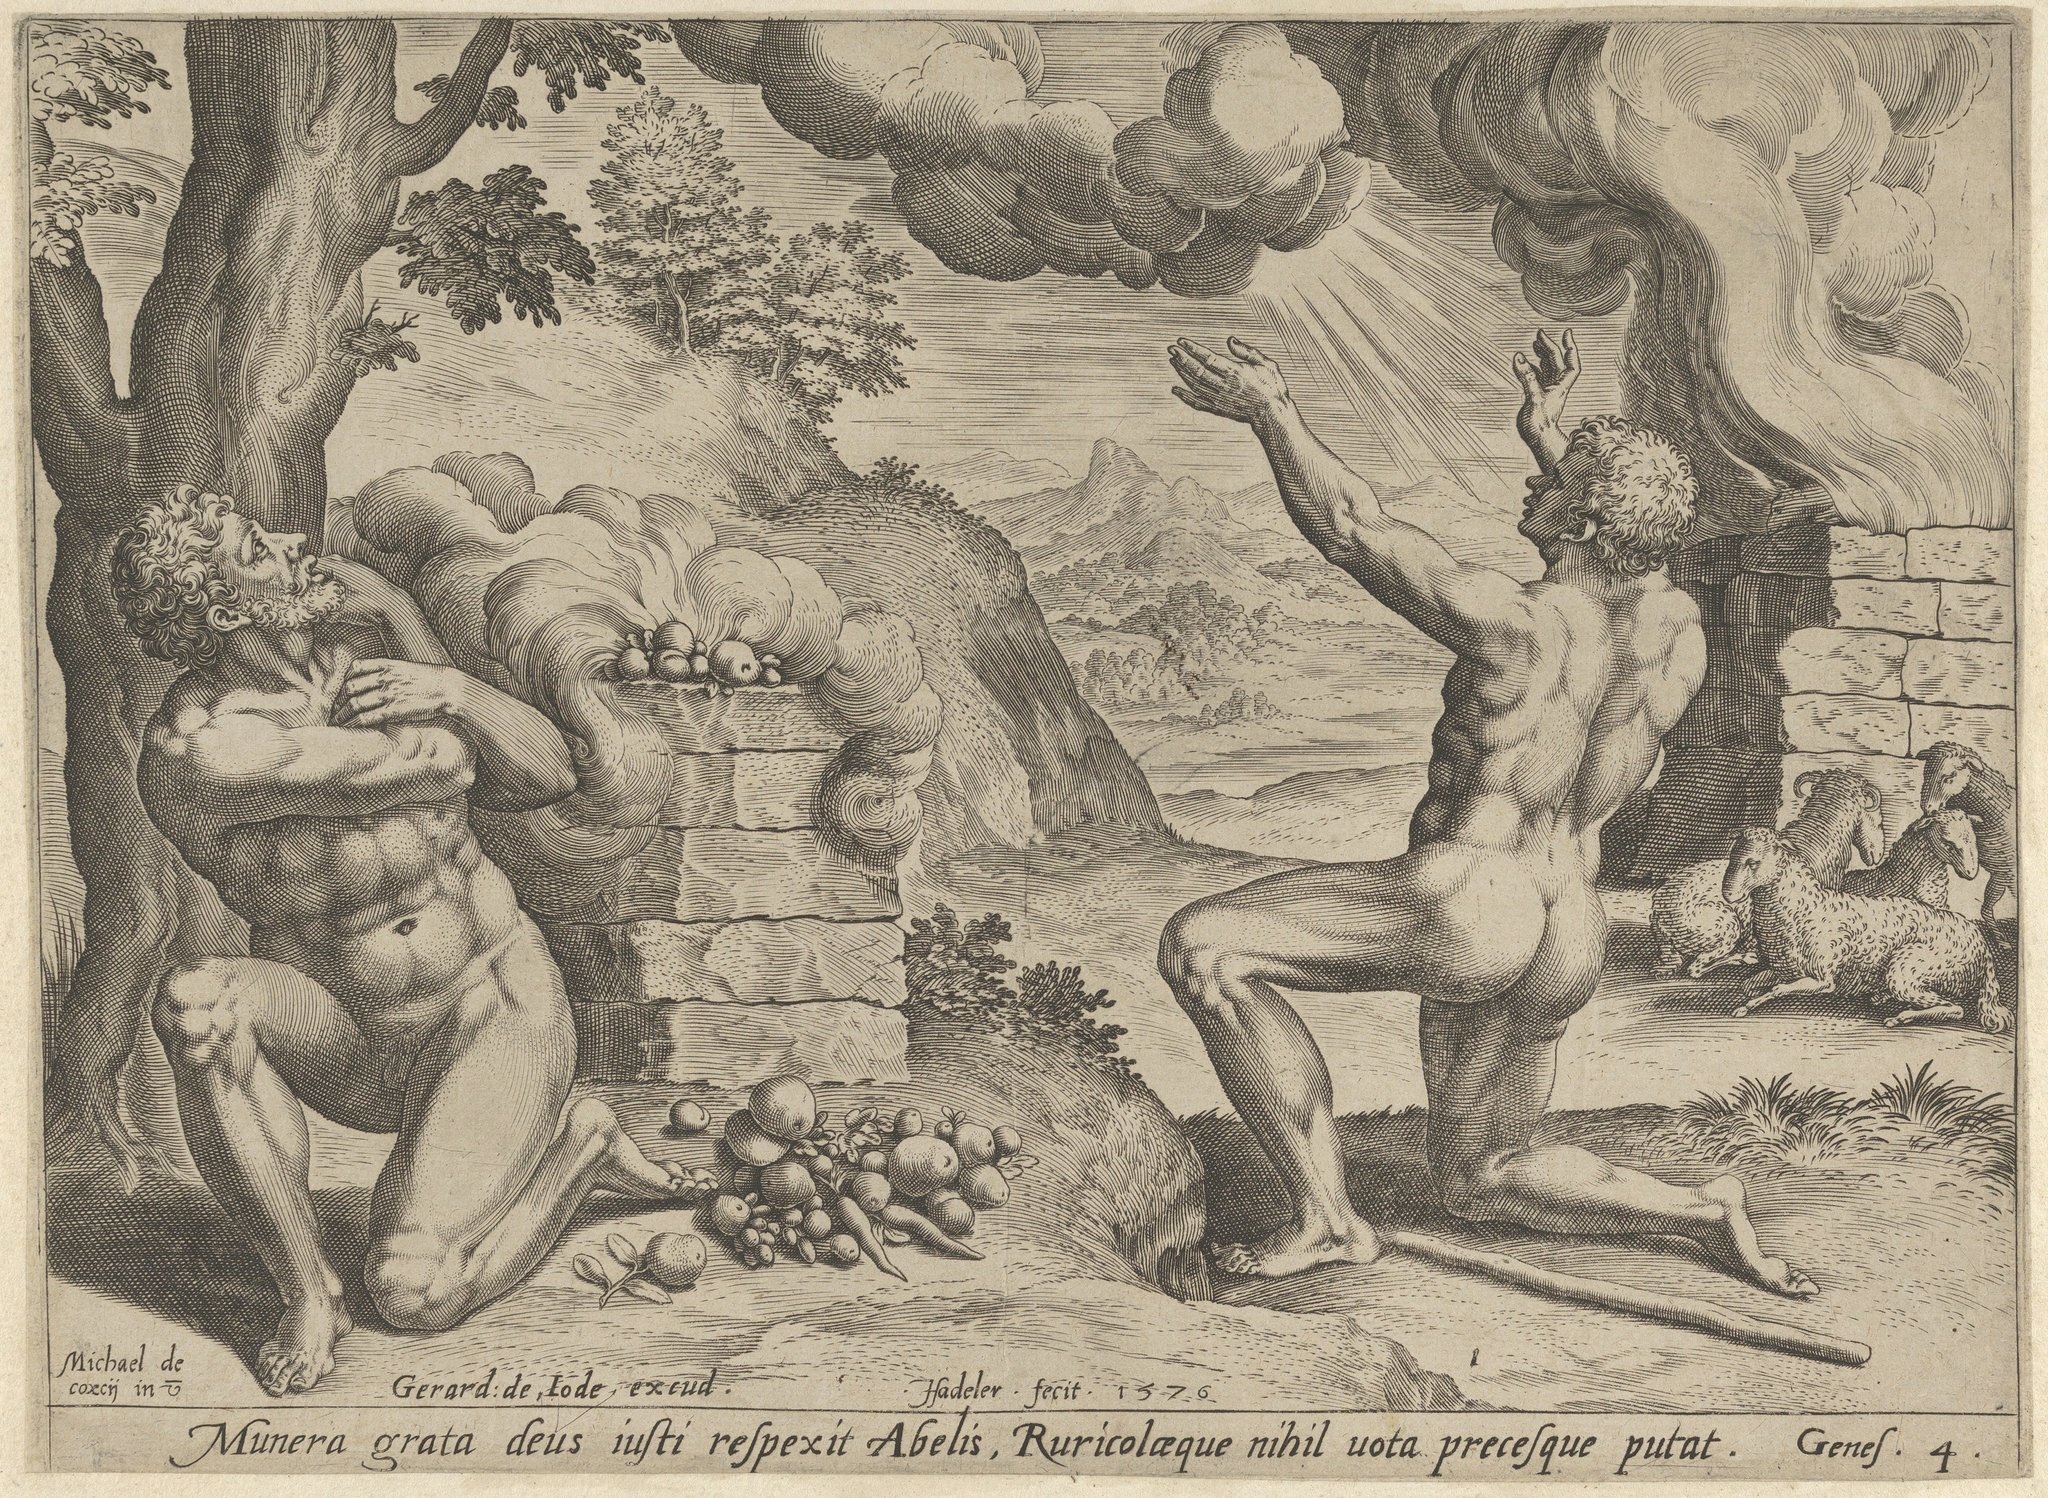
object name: print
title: The Sacrifice of Abel, plate 1 from "The Story of Cain and Abel"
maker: johann sadeler (i)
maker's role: artist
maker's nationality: netherlandish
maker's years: 1550-1601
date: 1576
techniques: engraving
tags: sheep,abel,cain,praying